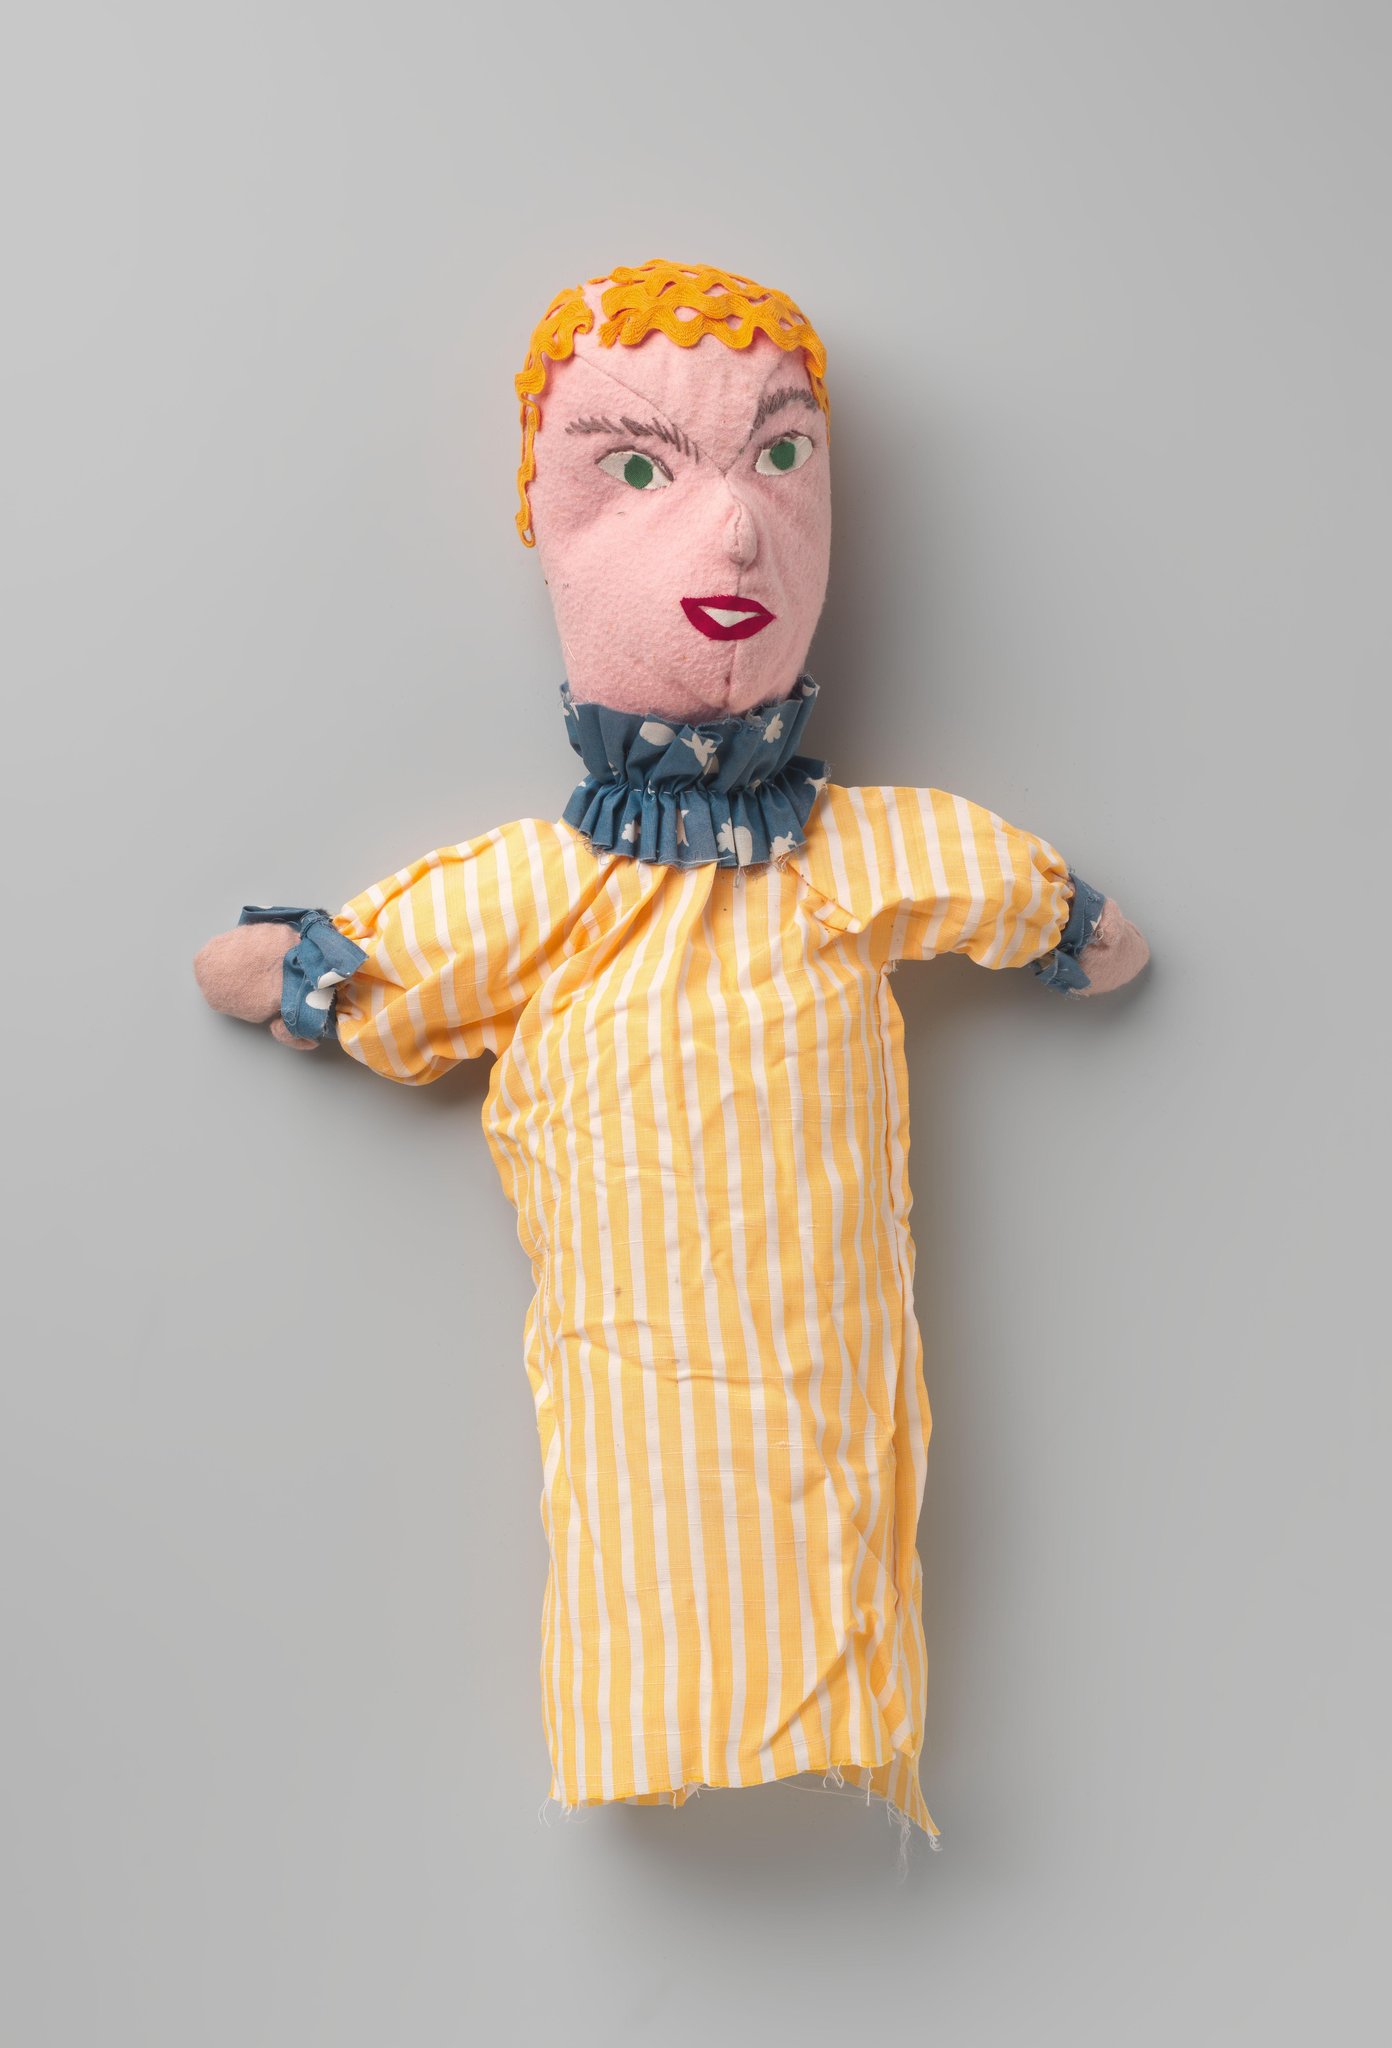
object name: doll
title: Pop, voorstellende mejuffrouw Erkelens, conservatrice textiel in het Rijksmuseum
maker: beate c.g. gleistein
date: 1959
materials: textile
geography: amsterdam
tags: utrecht, rijksmuseum amsterdam, anna maria louise elisabeth mulder-erkelens, amsterdam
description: Pop van textiel gemaakt voor het afscheid van de heer Roëll als directeur van het Rijksmuseum.